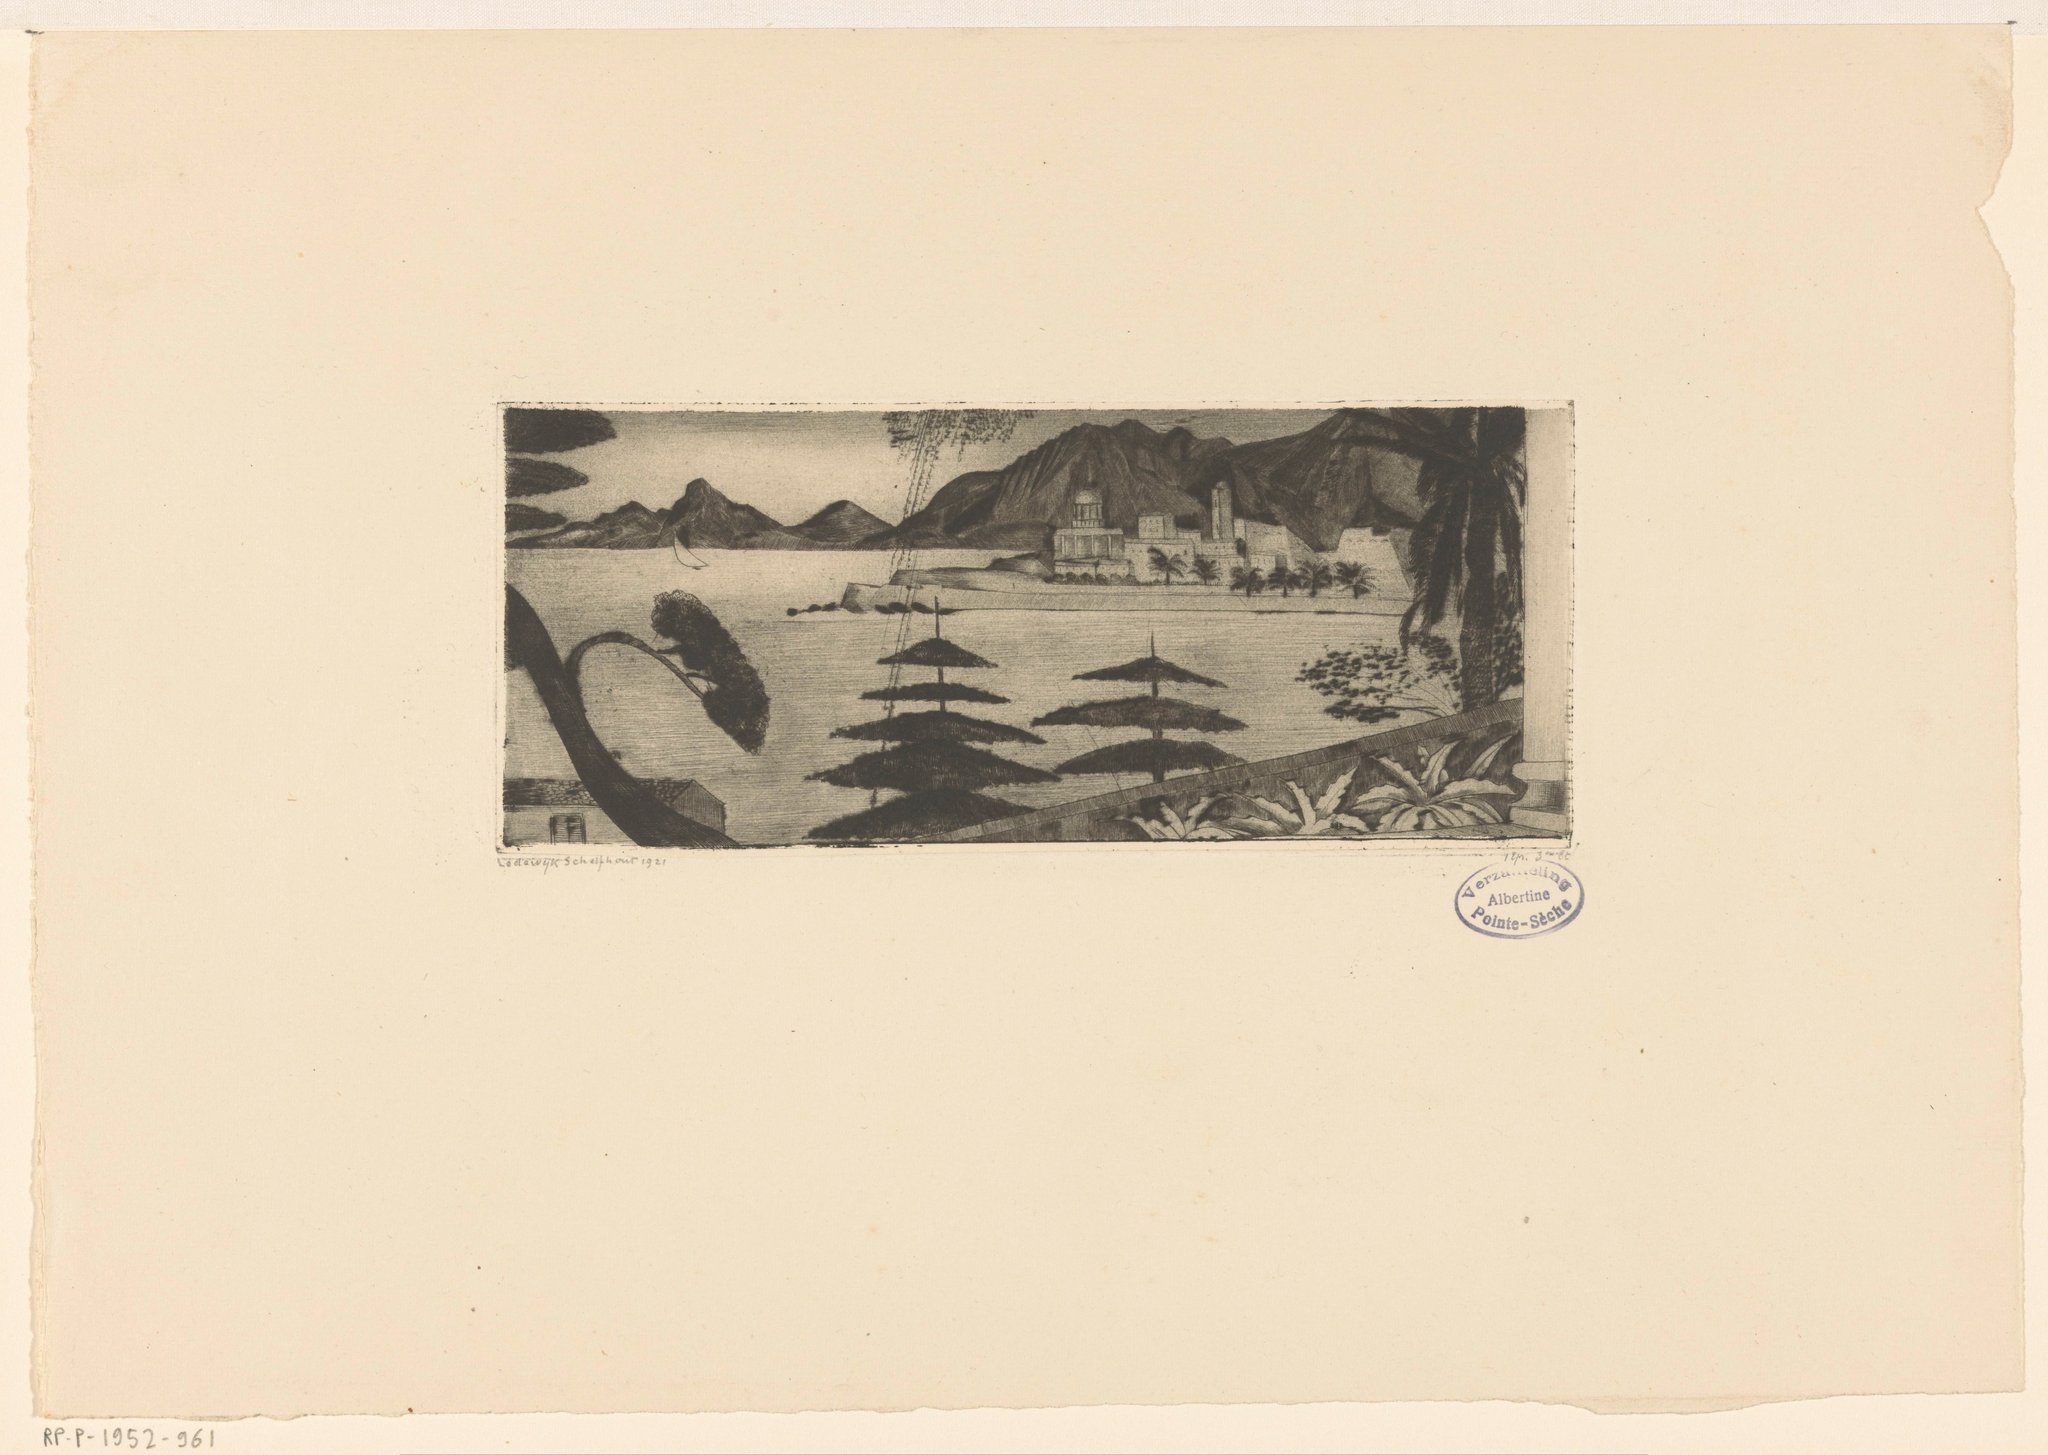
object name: print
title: Ajaccio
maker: lodewijk schelfhout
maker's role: draughtsman, print maker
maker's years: 1881-1943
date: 1921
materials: paper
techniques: drypoint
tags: gulf, bay, city-view, and landscape with man-made constructions, mountains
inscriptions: collector's mark: Lugt 2228, collector's mark: Lugt 5i, collector's mark: Lugt 2760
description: De stad Ajaccio en de omliggende baai op het eiland Corsica. Op de achtergrond bergen.